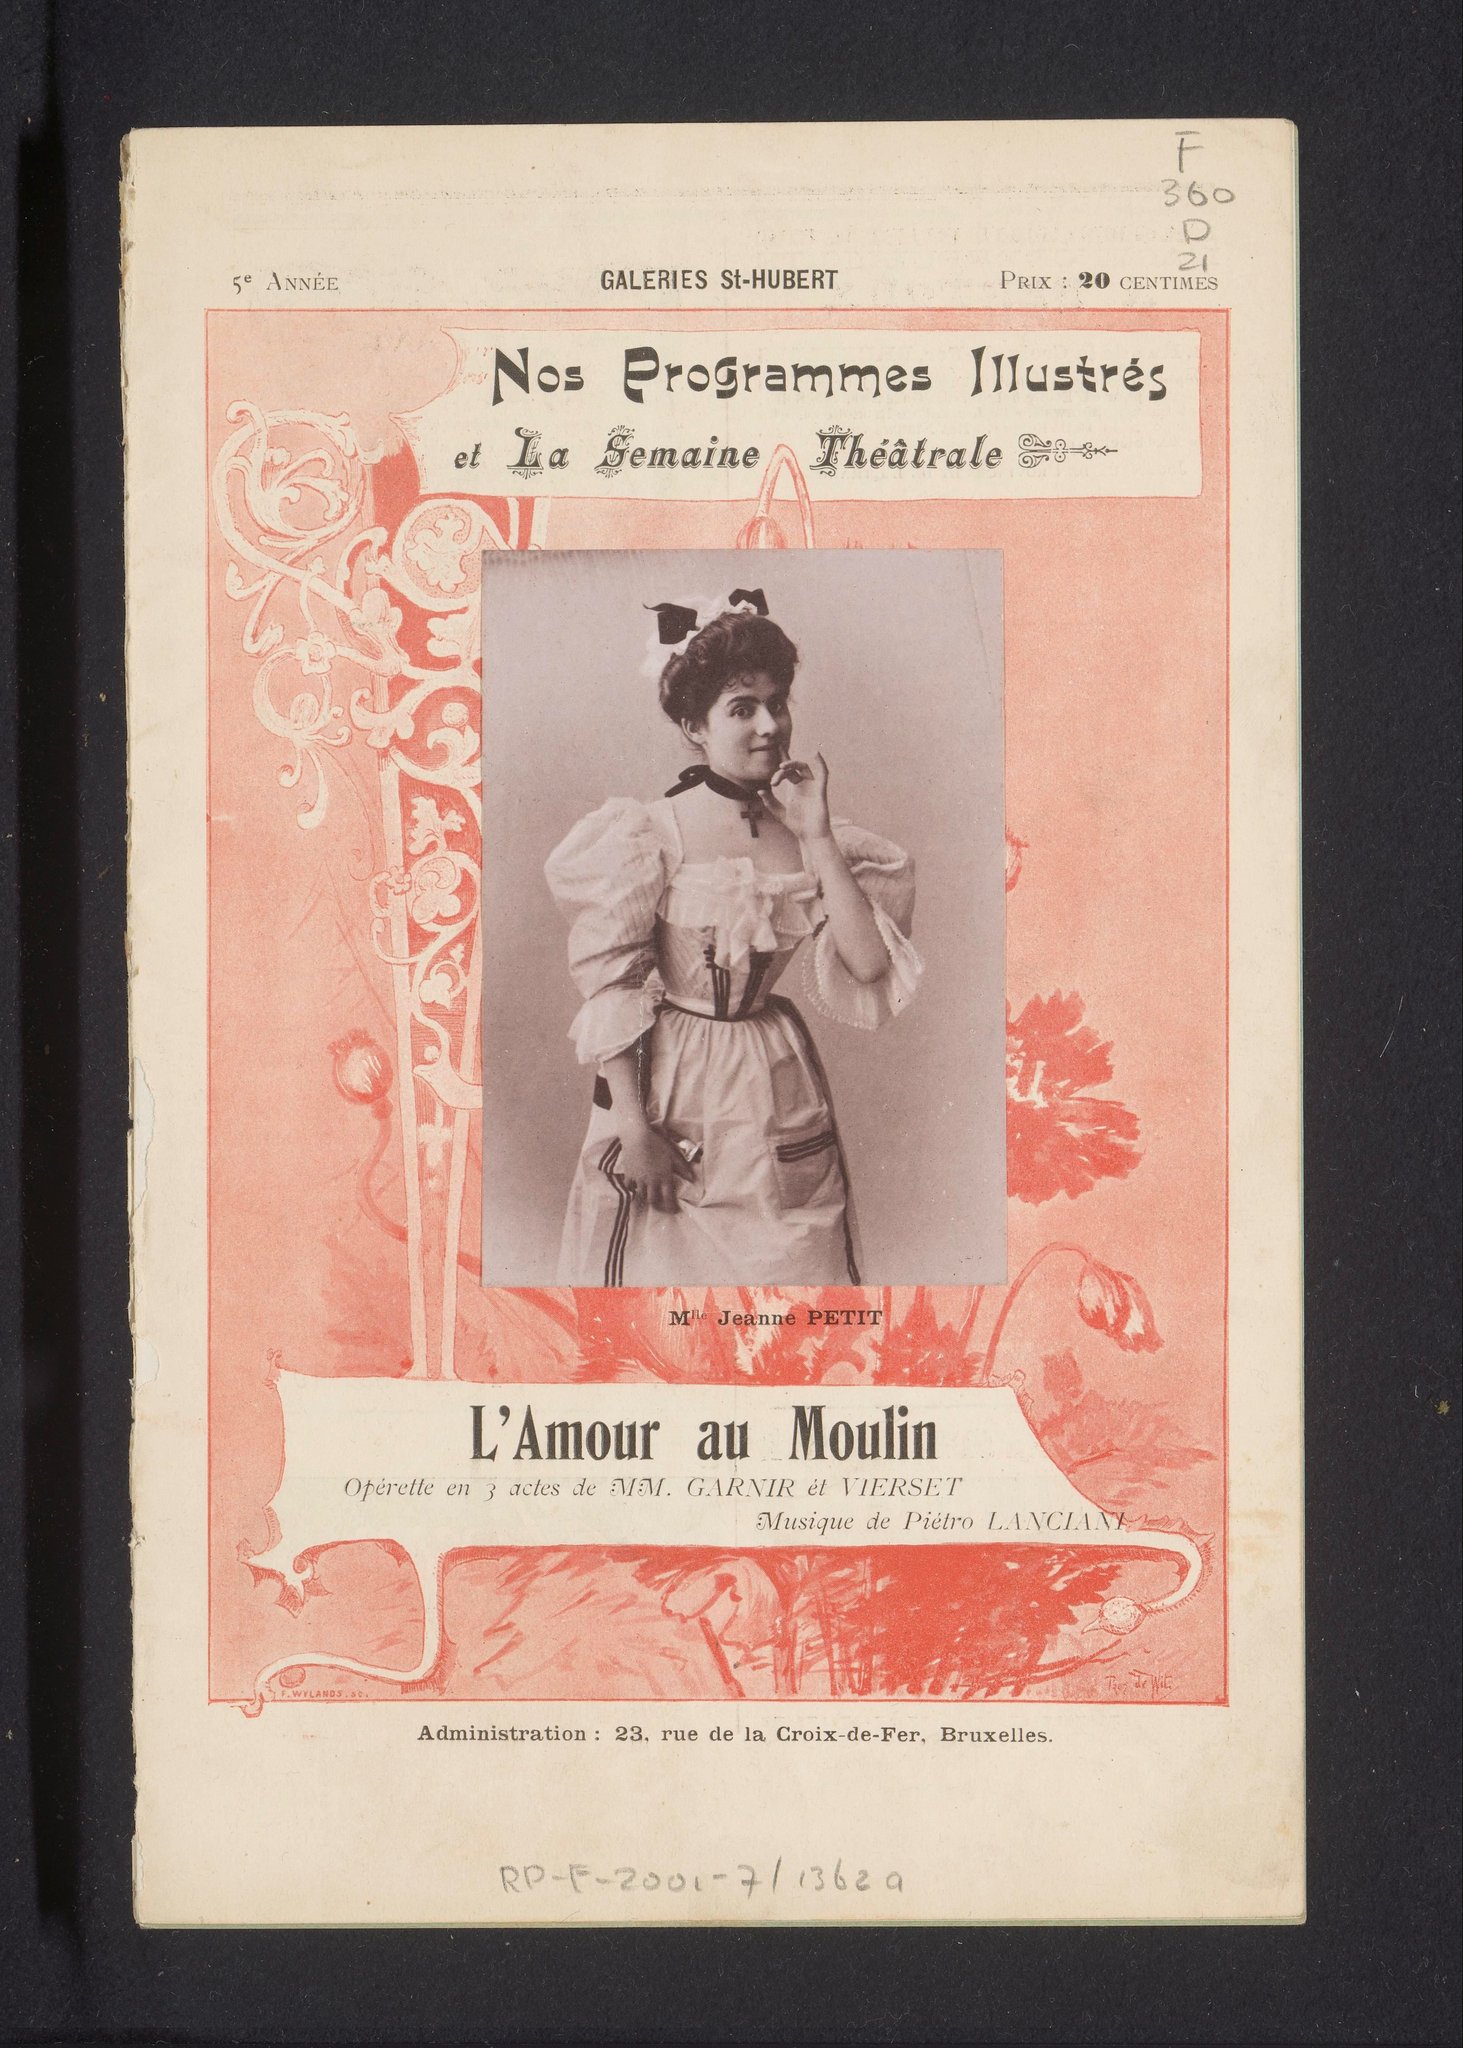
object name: magazine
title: Nos programmes illustrés et la semaine théâtrale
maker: edgard lyon-claesen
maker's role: printer, publisher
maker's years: 1857-1935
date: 1900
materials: paper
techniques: photograph, printing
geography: brussels